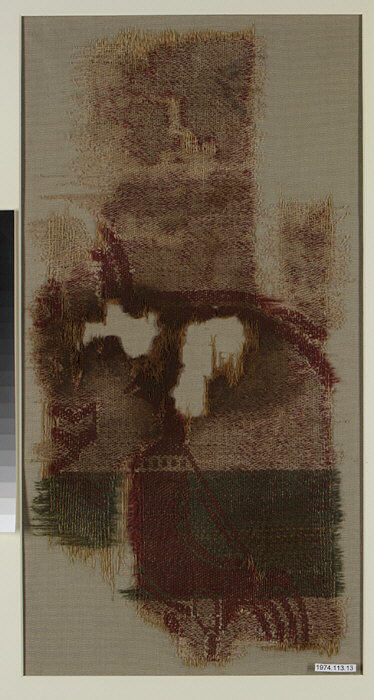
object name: textile fragment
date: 901-1100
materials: cotton, wool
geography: iran